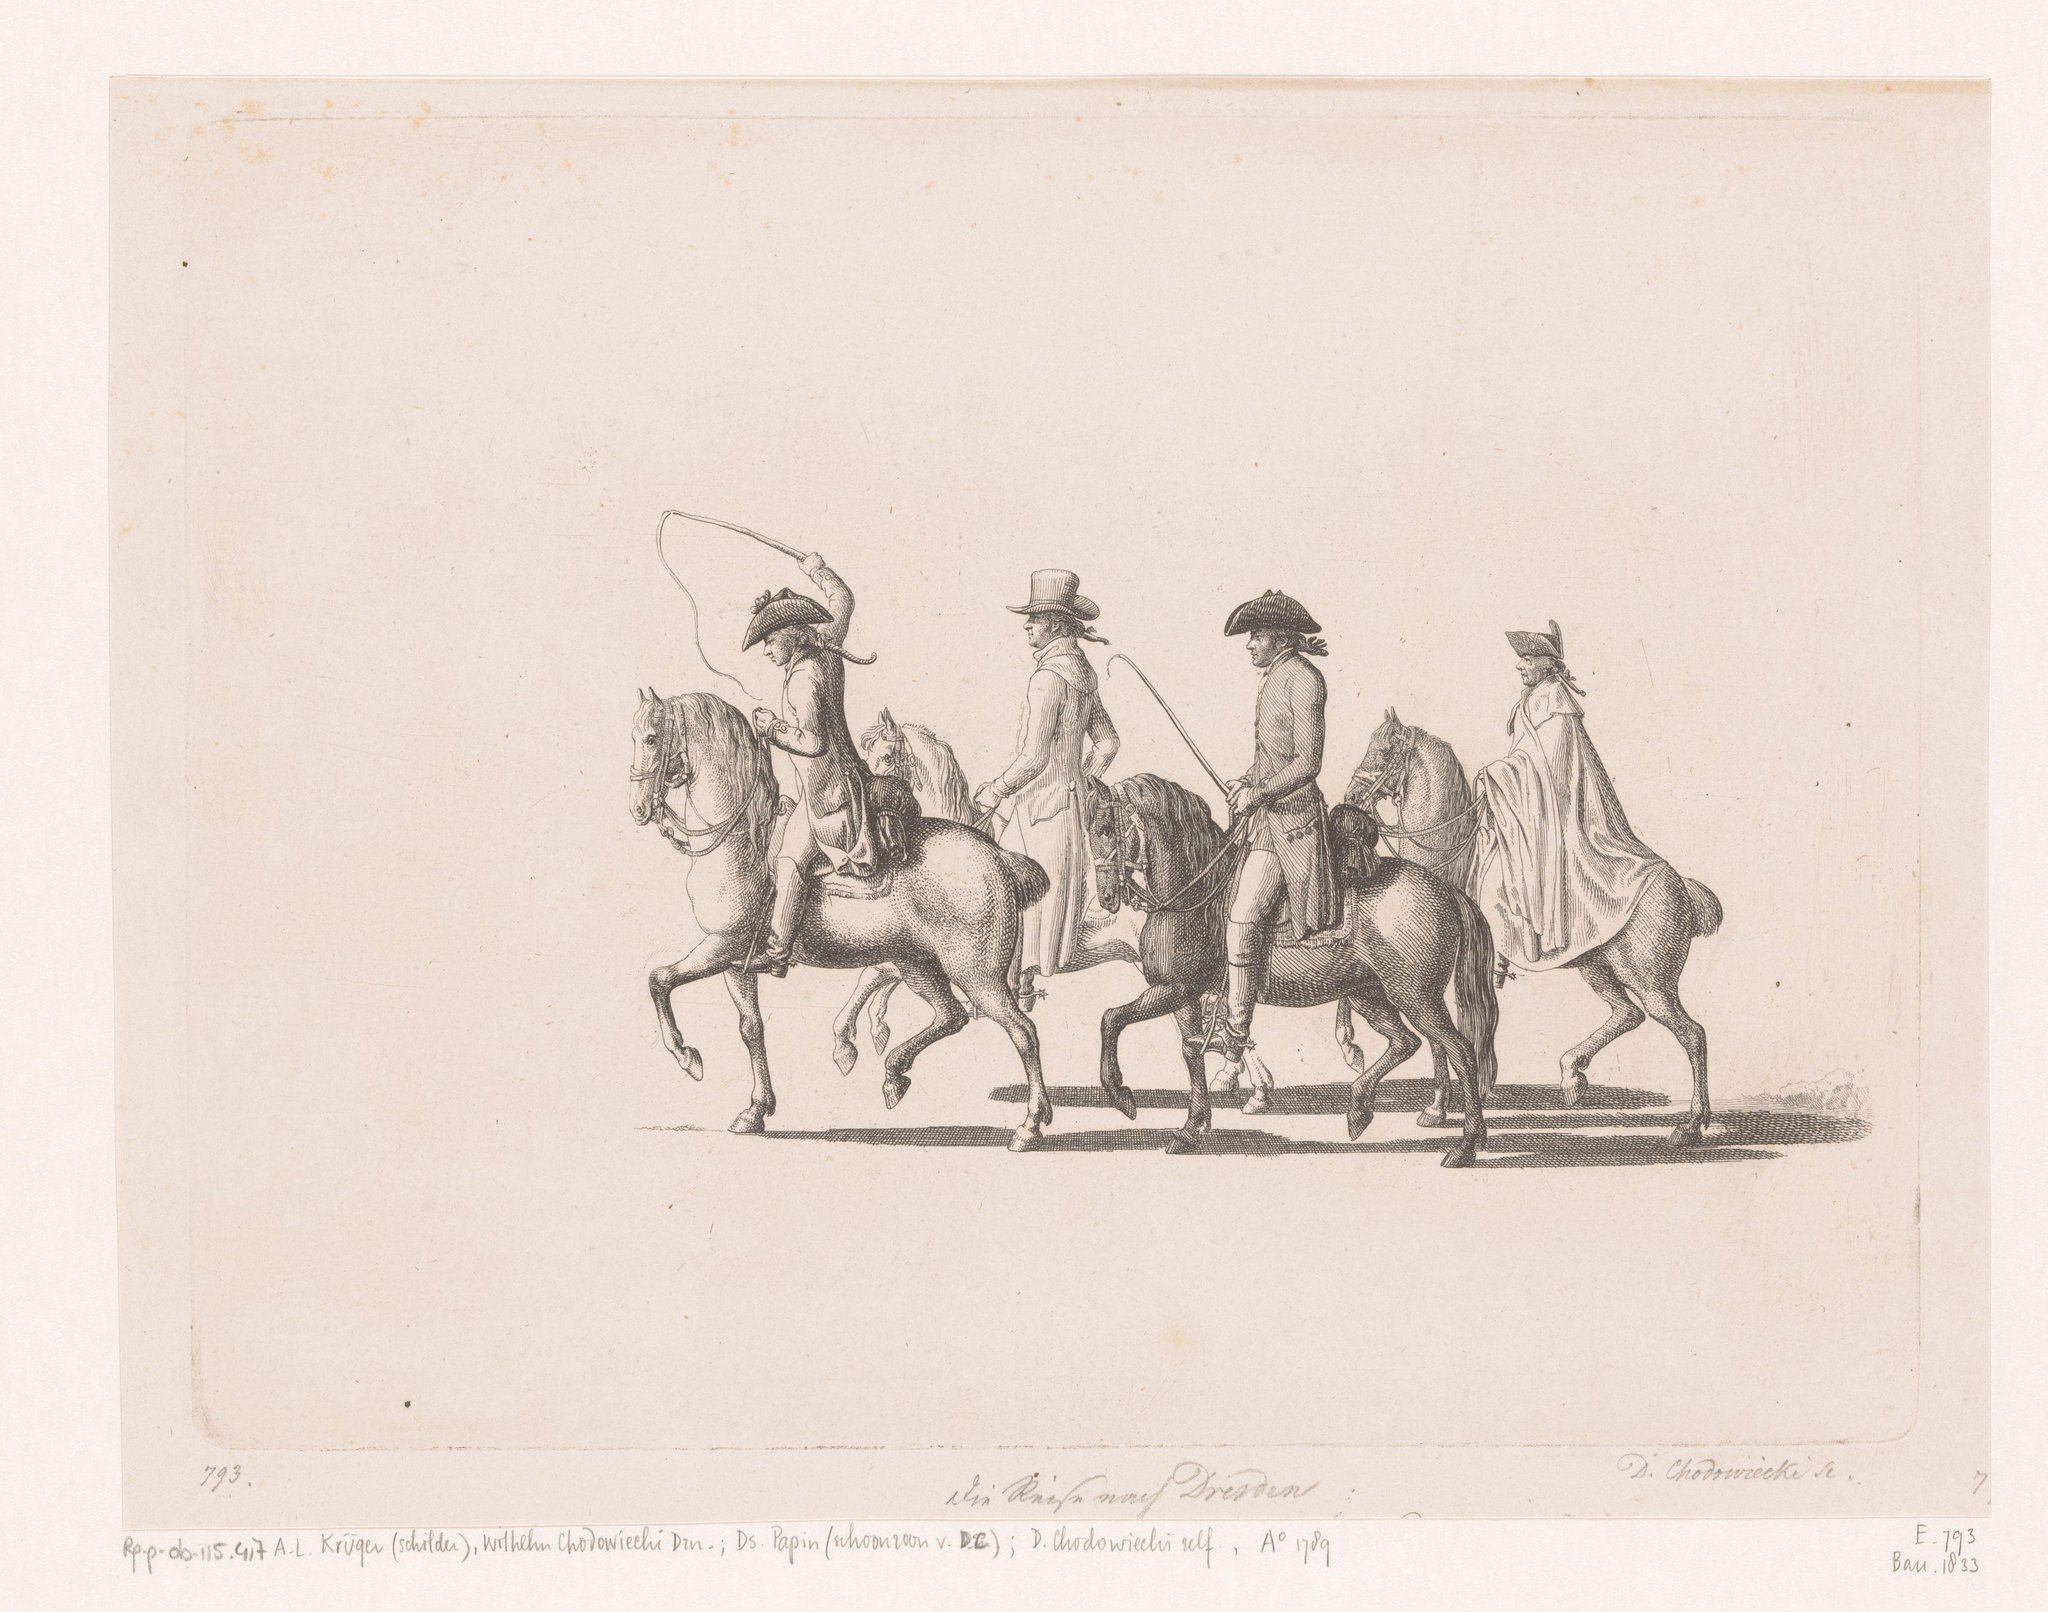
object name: print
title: Albina herkent de ridder als Edmund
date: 1791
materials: paper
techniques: etching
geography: berlin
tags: literature, embracing each other, kissing, knight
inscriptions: collector's mark: Lugt 2228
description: Prent gebruikt voor: Mühlenpfordt, Georg. Scenen aus den Ritterzeiten. Kopenhagen: Christian Gottlob Proft, 1791.